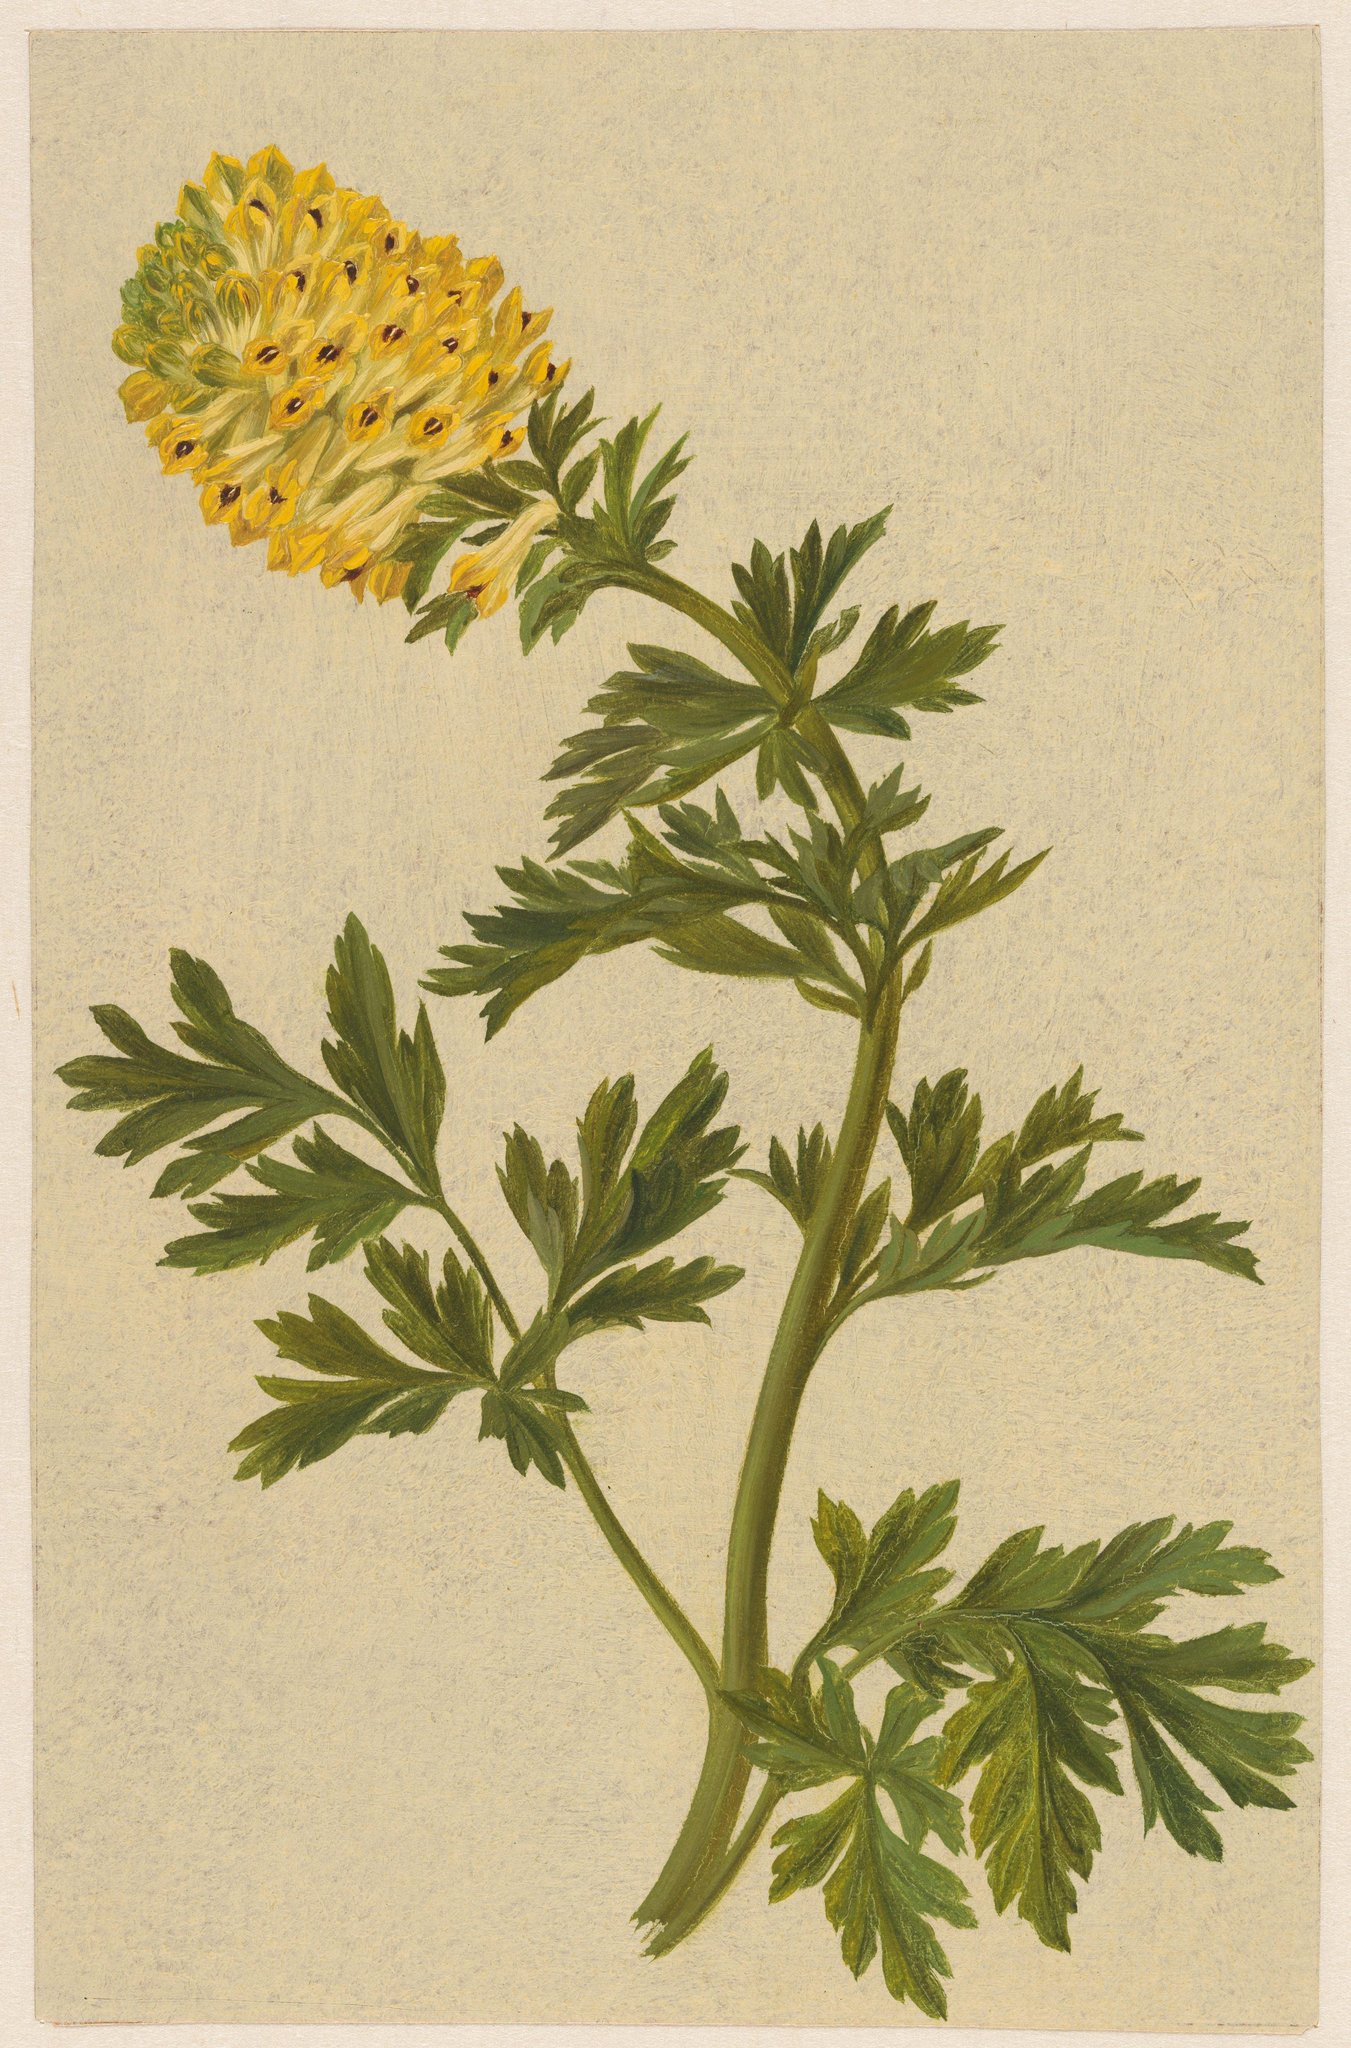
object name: drawing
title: Takje met een bloem van de Corydalis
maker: d. van alphen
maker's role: draughtsman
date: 1874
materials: oil, paper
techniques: brush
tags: flowers: corydalis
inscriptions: date: ‘1874’